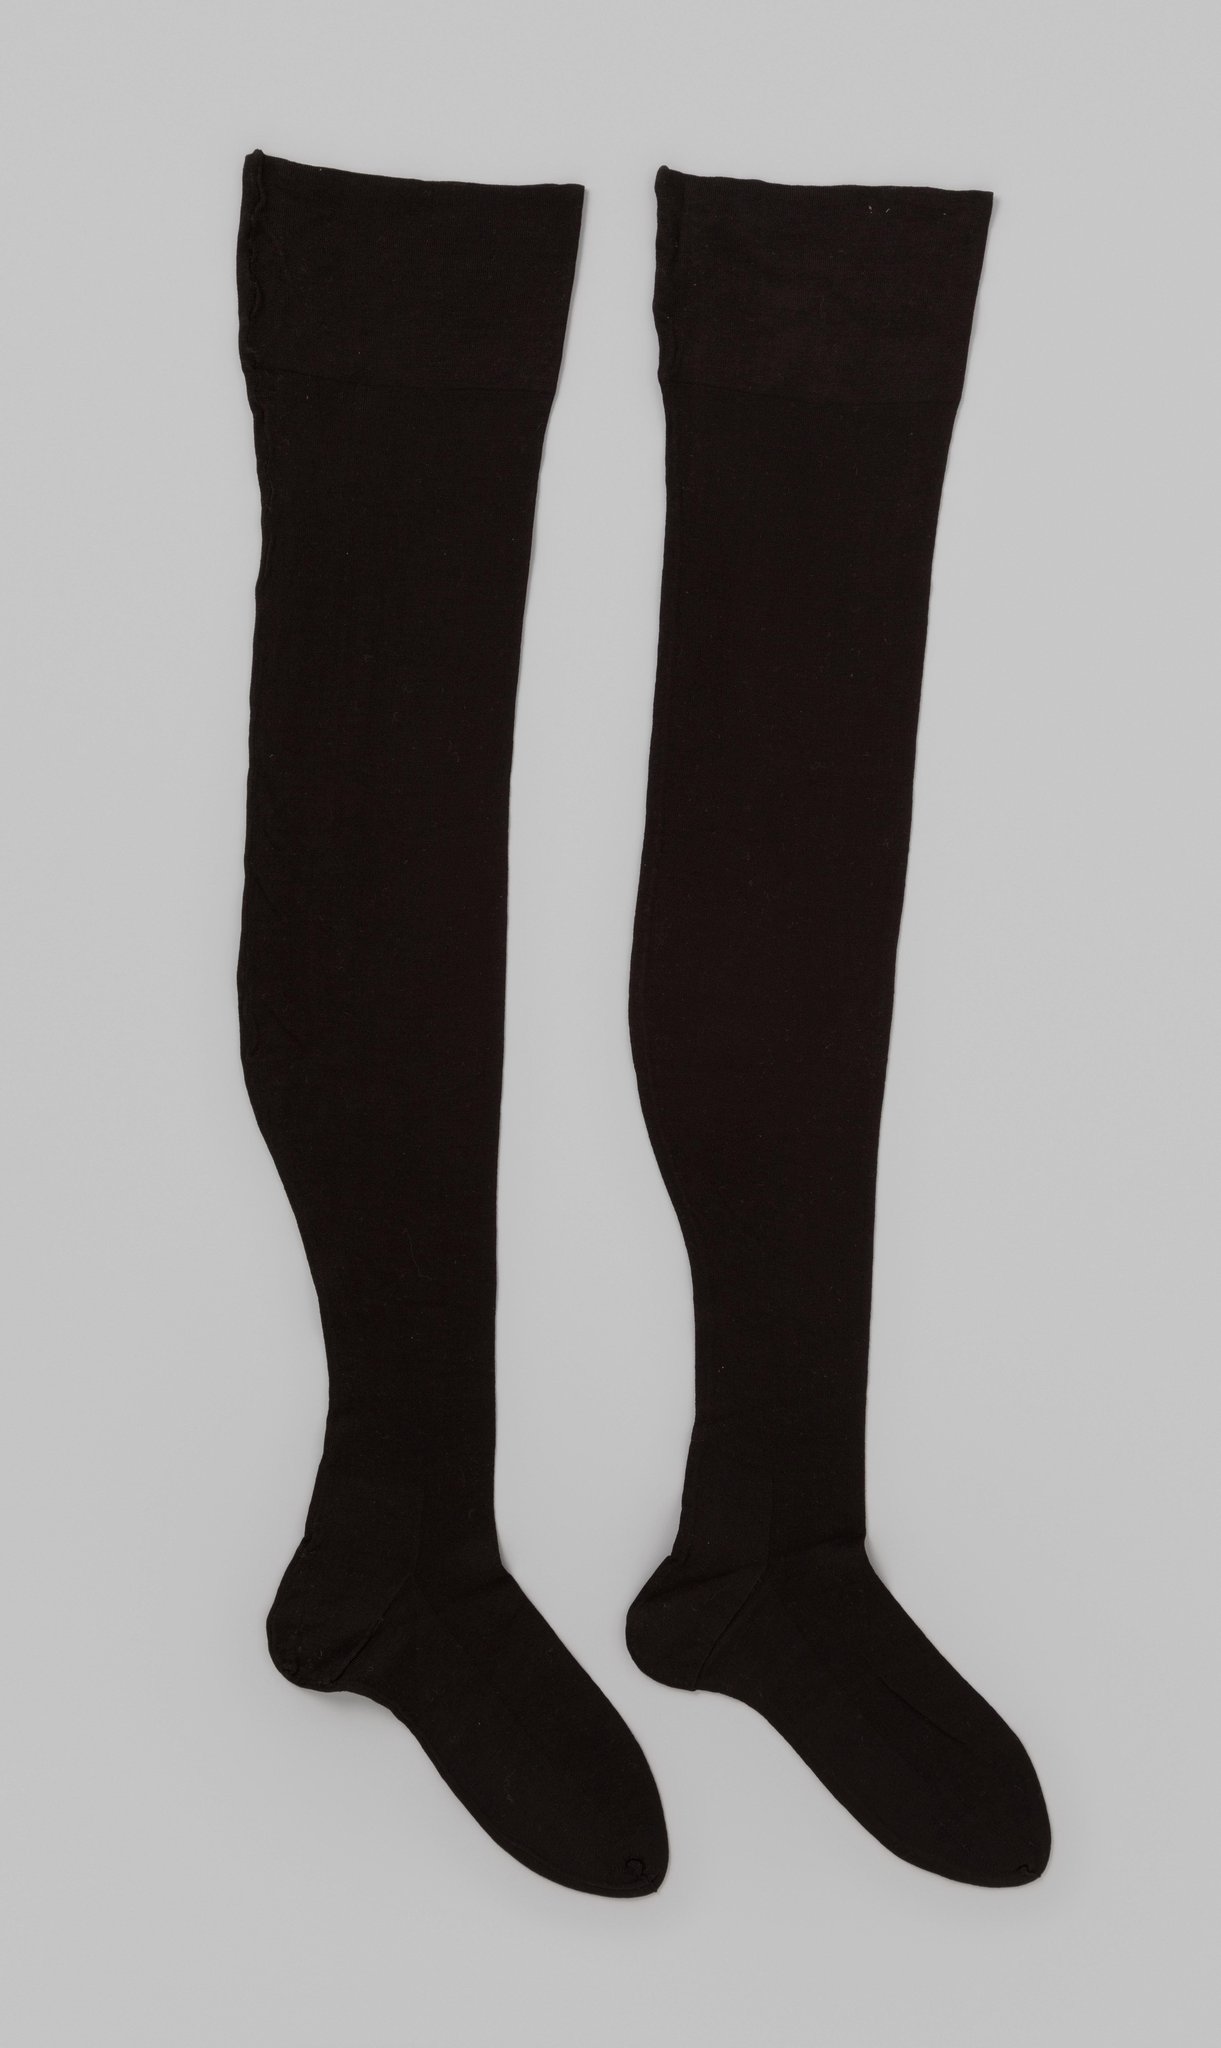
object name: clothing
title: Kous van effen zwarte katoenen tricot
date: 1925-1950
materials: cotton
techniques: knitting, printing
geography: netherlands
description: Kous van zwart tricot, fils d'écosse, fijn katoen, iets glanzend. Met naad en vierkante hiel. Breed dubbel boord.